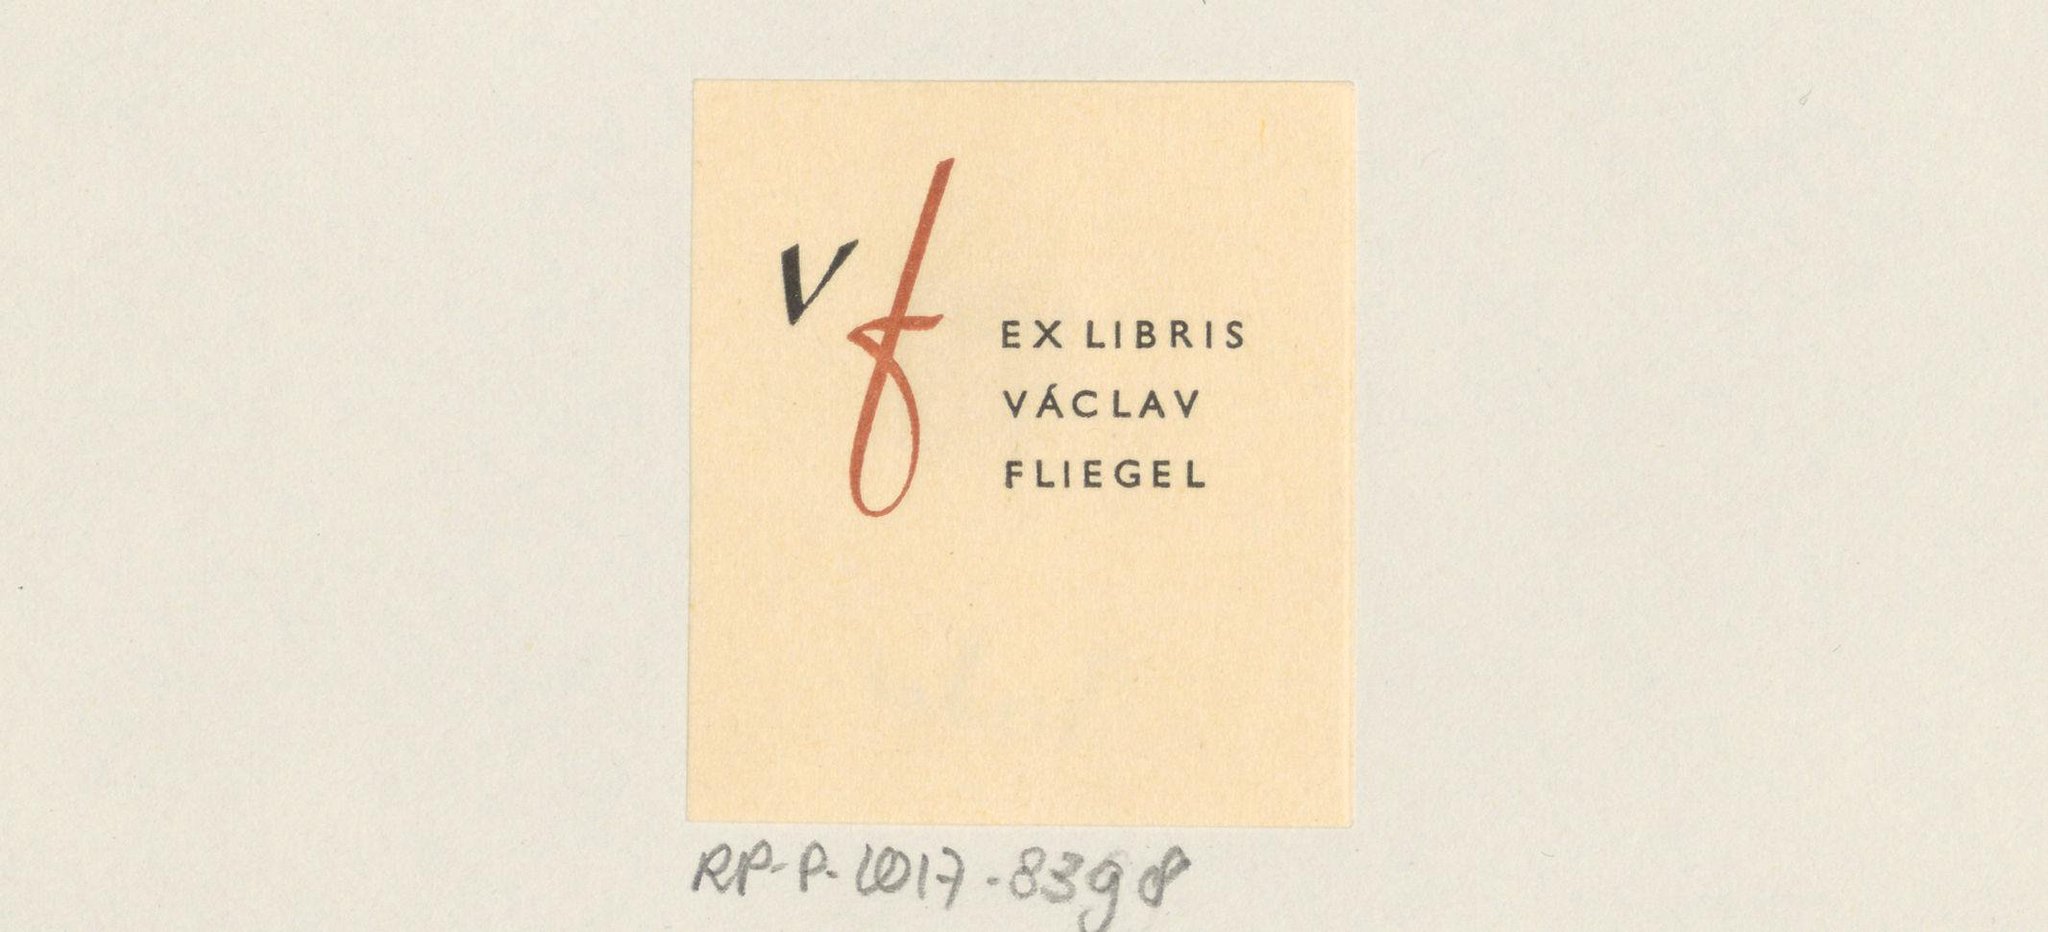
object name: bookplate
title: Ex libris van Václav Fliegel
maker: Anonymous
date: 1900-1999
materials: paper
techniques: printing block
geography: czech republic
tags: václav fliegel